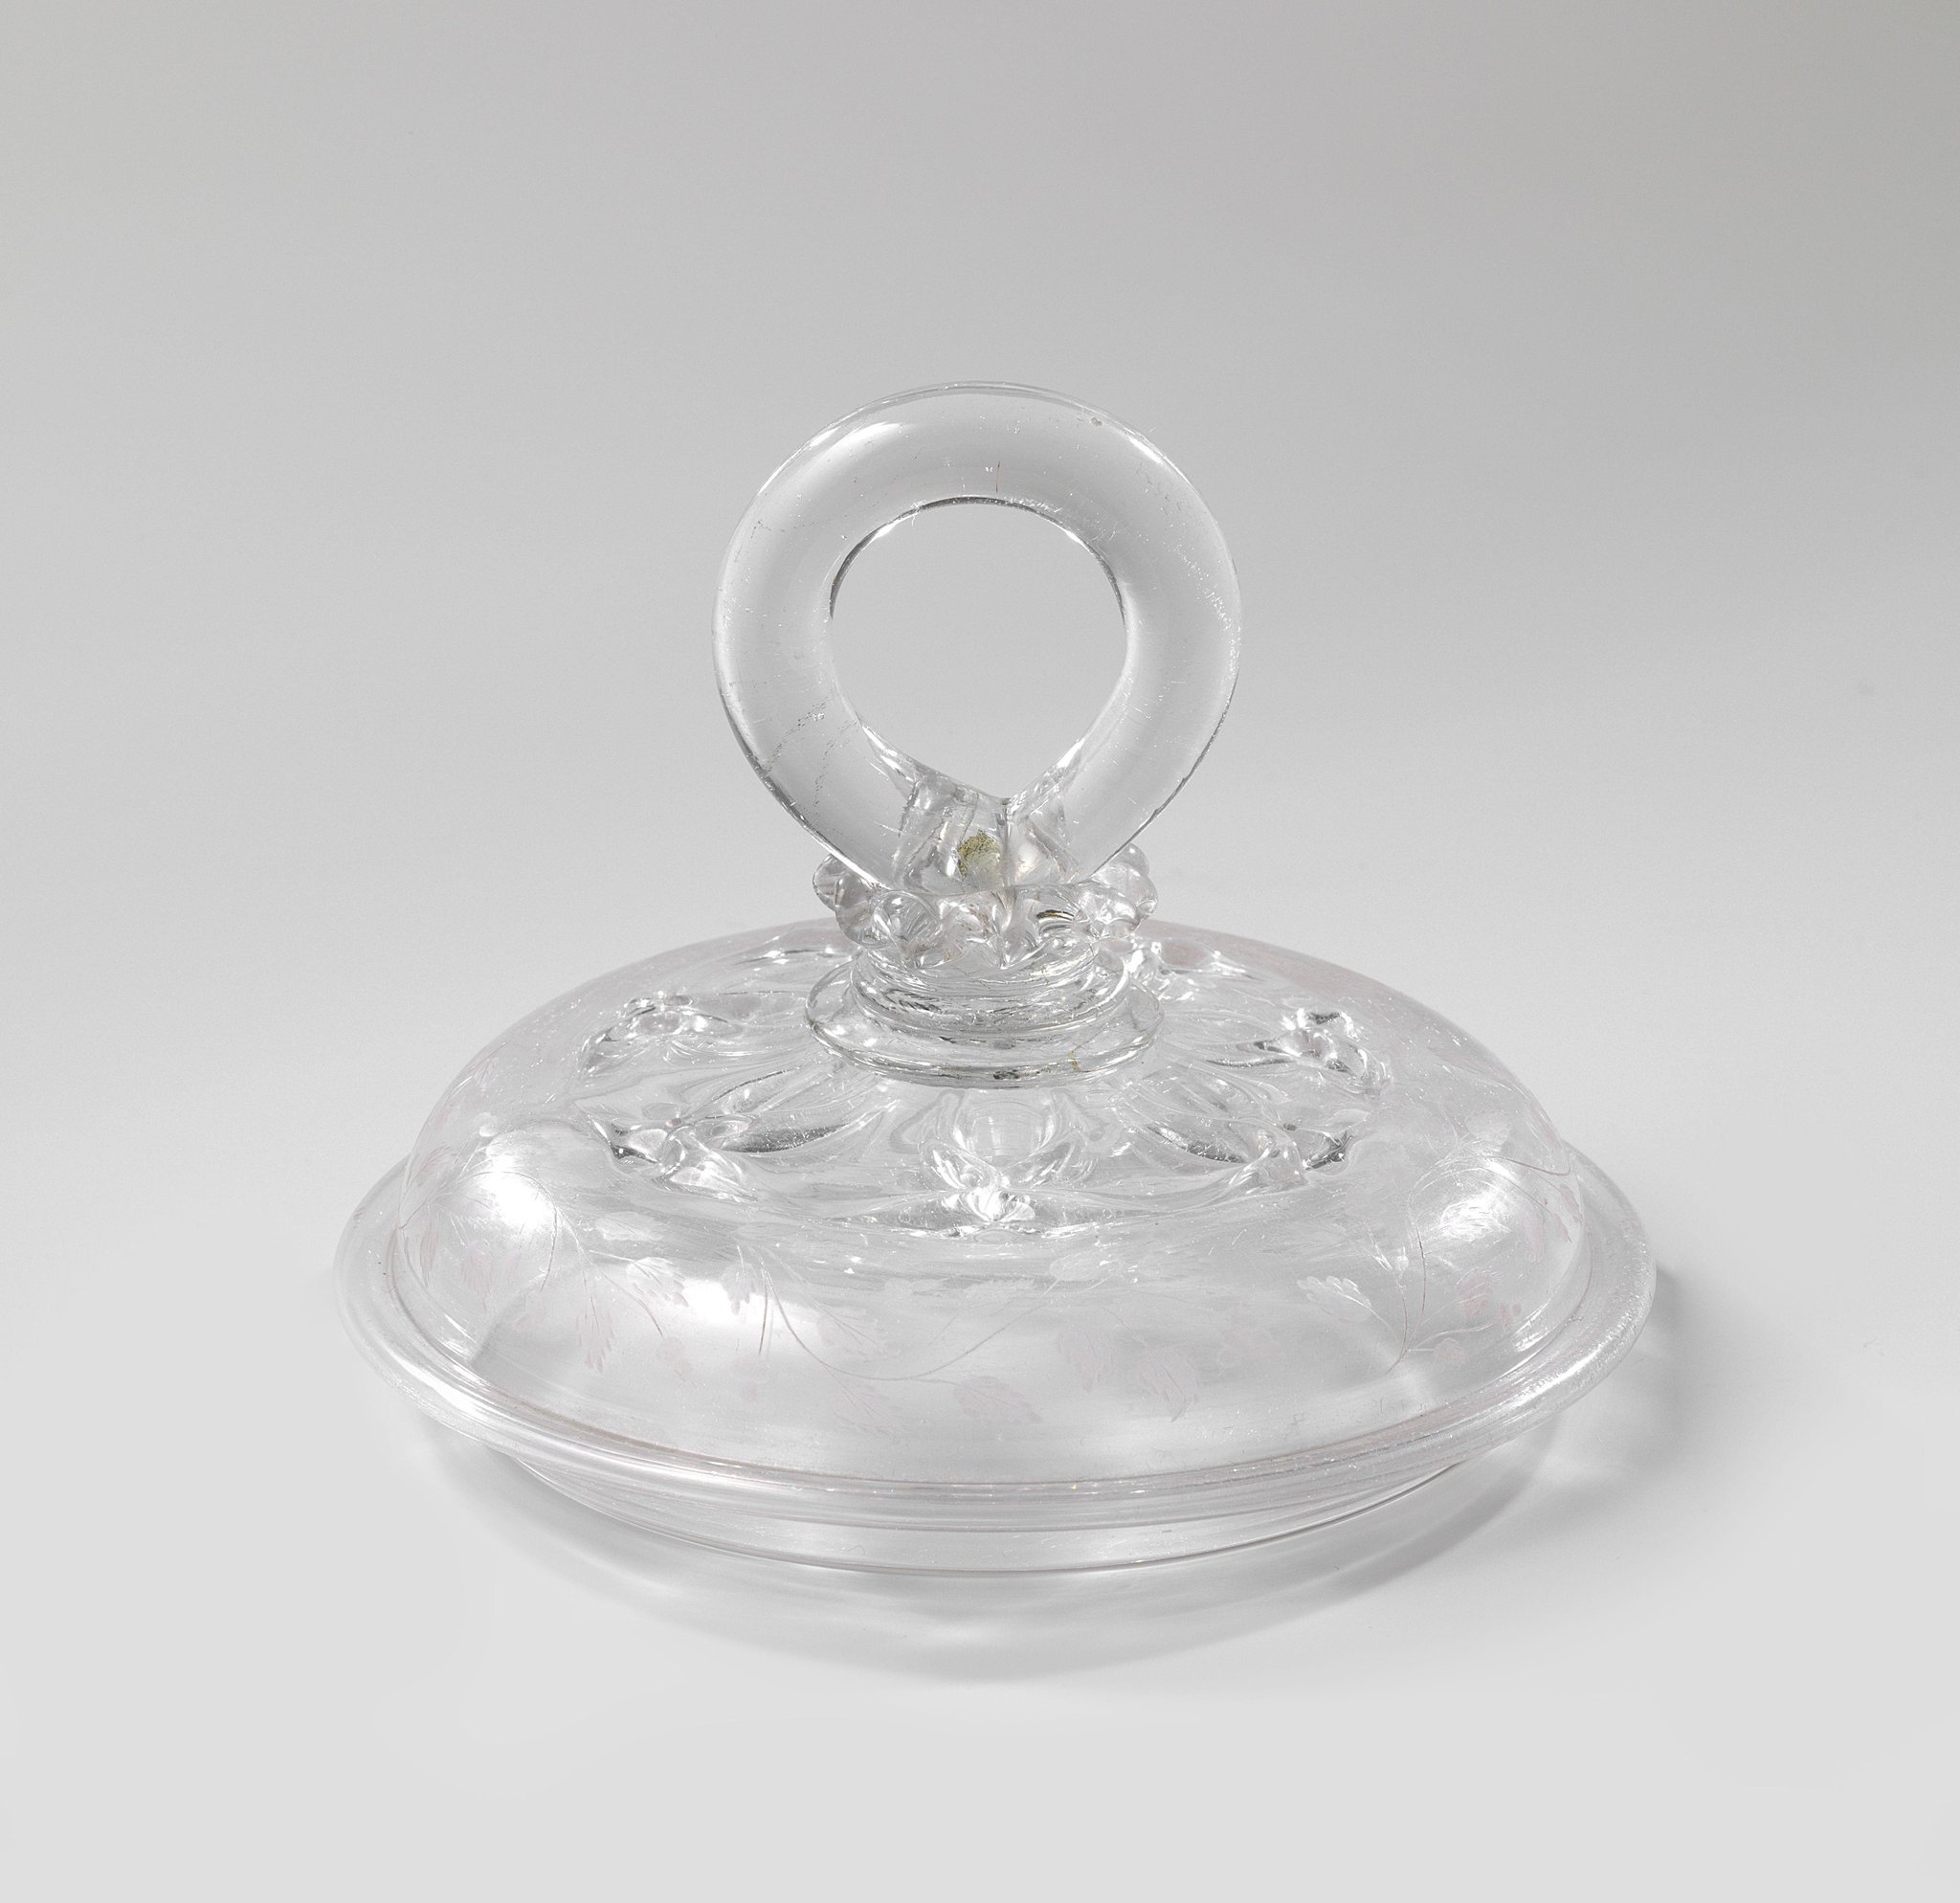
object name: lid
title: Deksel van een bokaal met ringvormige knop en eikenblad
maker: Anonymous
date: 1680-1700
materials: glass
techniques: façon de venise, glassblowing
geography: northern netherlands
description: Gewelfd deksel van helder, kleurloos glas, met in de vorm geblazen tangornament. Ringvormige knop. Op het deksel een doorlopende rand van takken met eikenblad in radgravure.